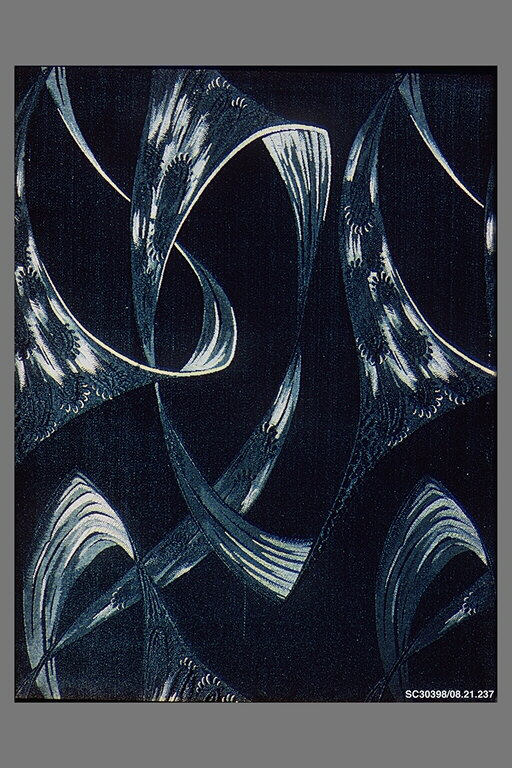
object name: textile sample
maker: Anonymous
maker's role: designer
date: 1900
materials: silk